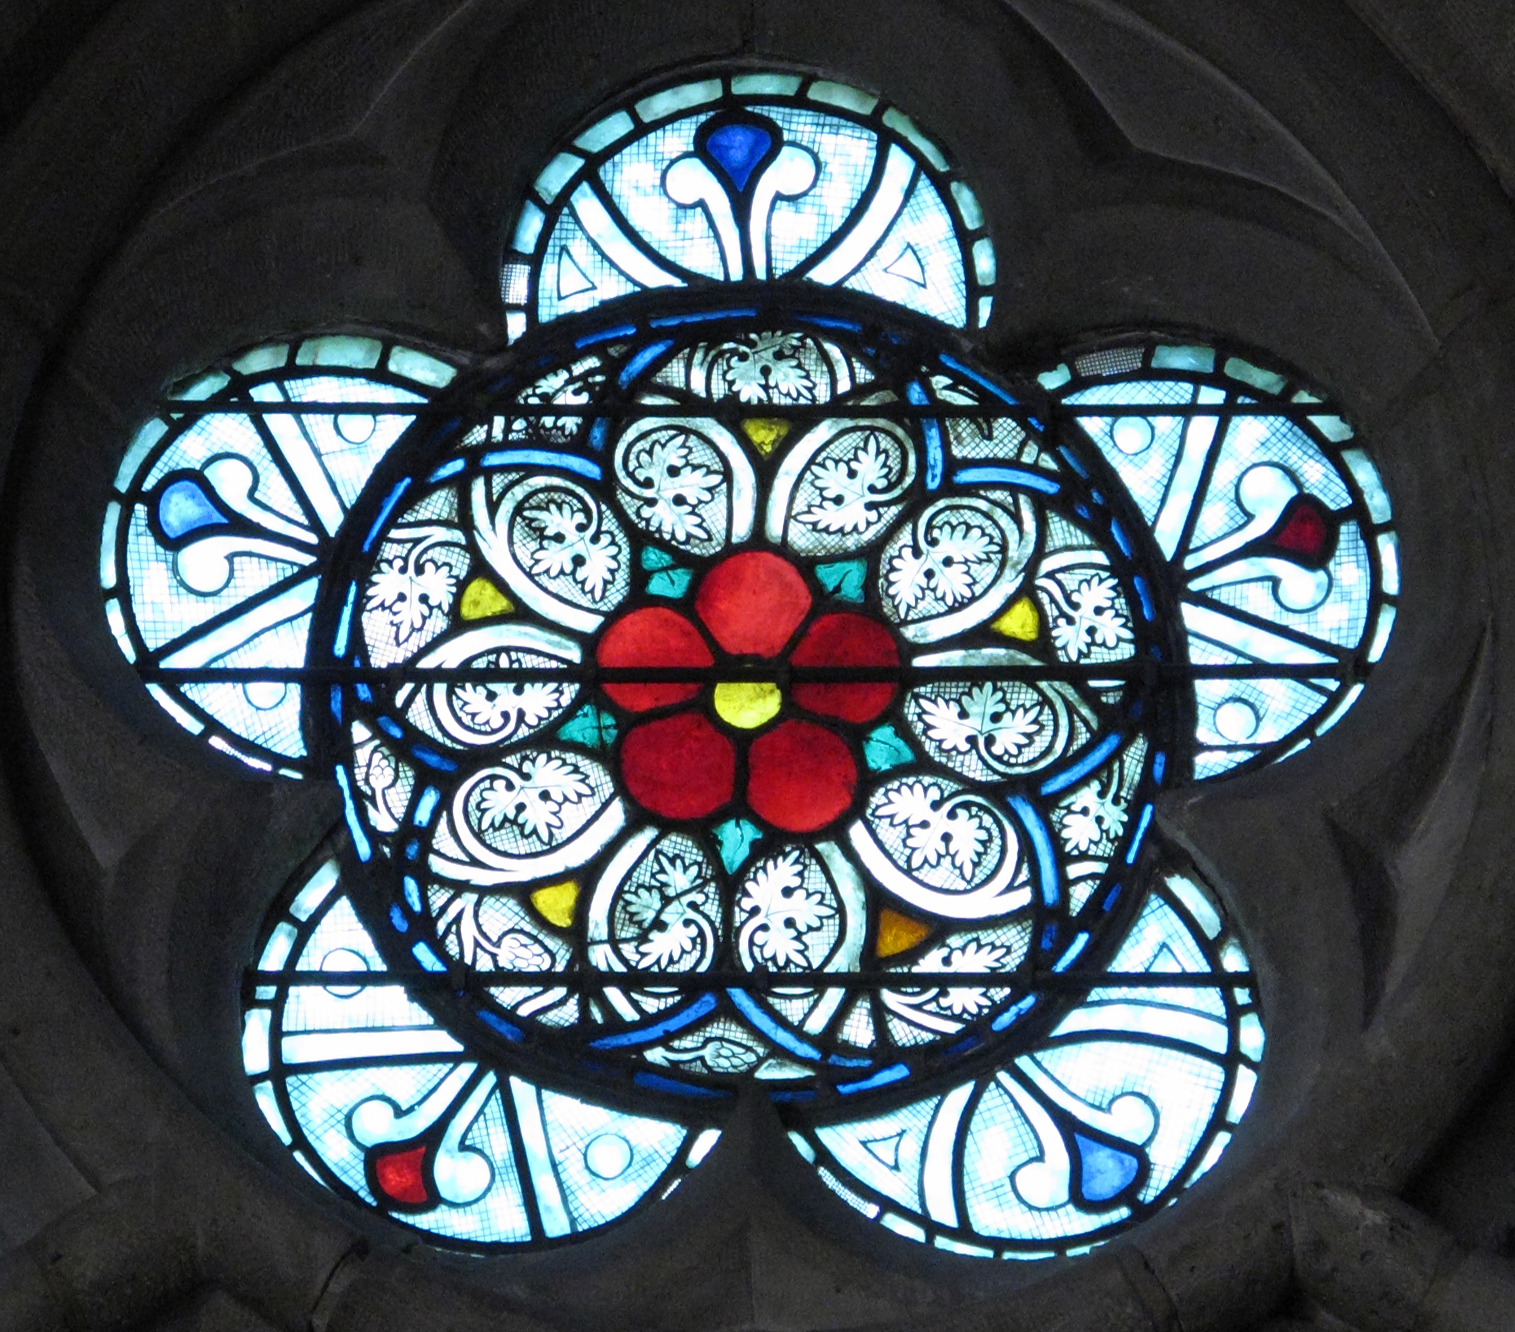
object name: roundel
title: Grisaille Roundel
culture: german or austrian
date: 1334-1366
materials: glass, metal, paint